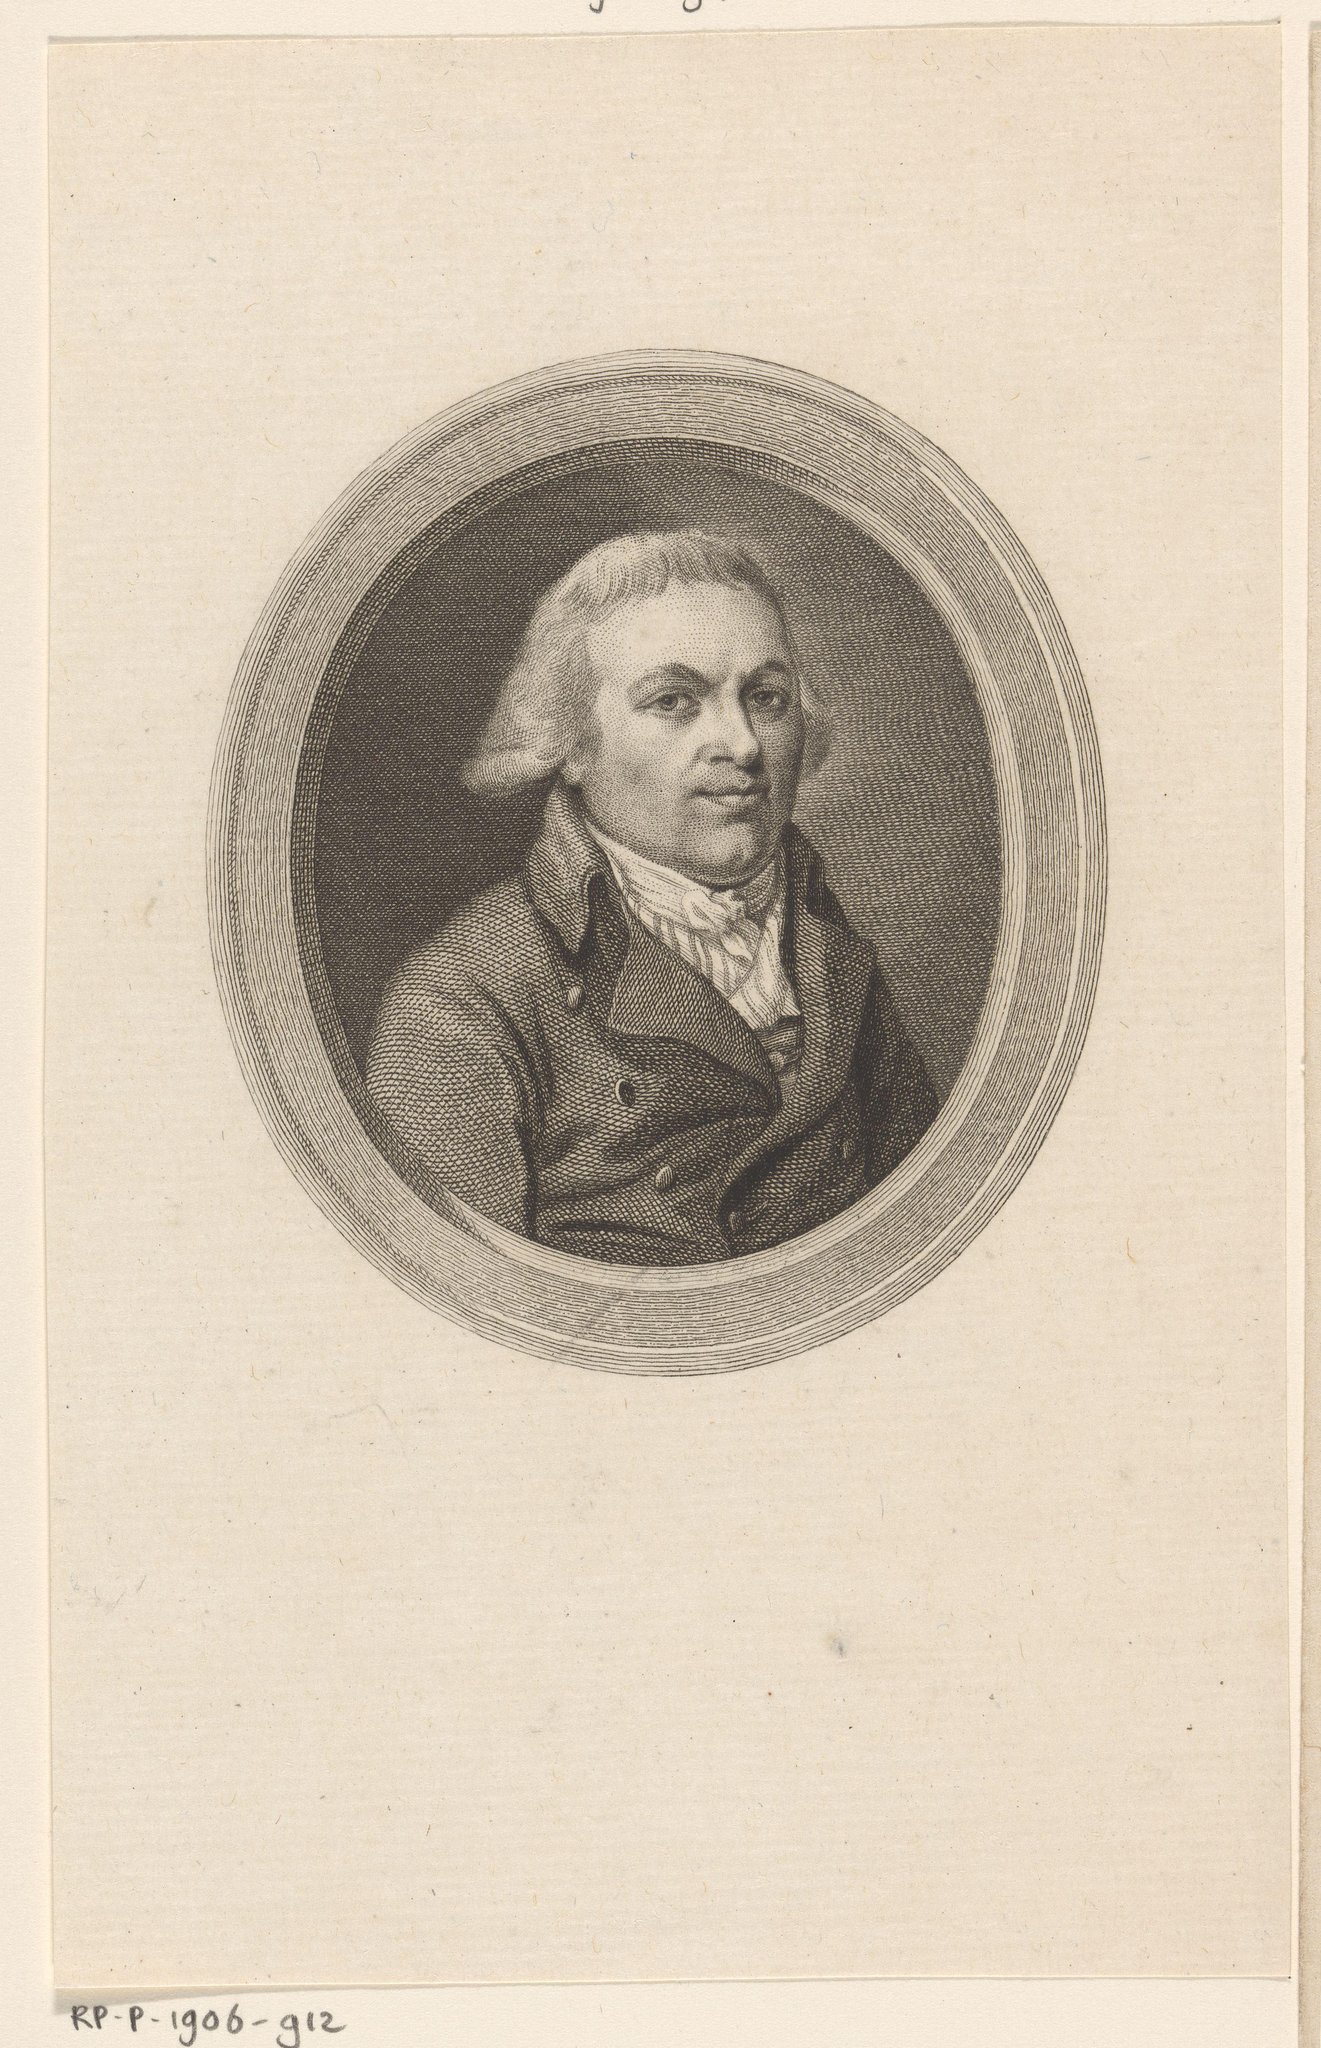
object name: print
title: Portret van Jan David Pasteur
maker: reinier vinkeles (i)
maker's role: draughtsman, print maker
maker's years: 1741-1816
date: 1786-1809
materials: paper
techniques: engraving, etching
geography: amsterdam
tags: leiden, jan david pasteur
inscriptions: collector's mark: Lugt 2228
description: Latere staat prent ook gebruikt als boekillustratie in: Wagenaar, Jan. Vaderlandsche historie, (...) ten vervolge van Wagenaars Vaderlandsche historie. Dl. 1-43. Amsterdam: Johannes Allart, 1786-1809.